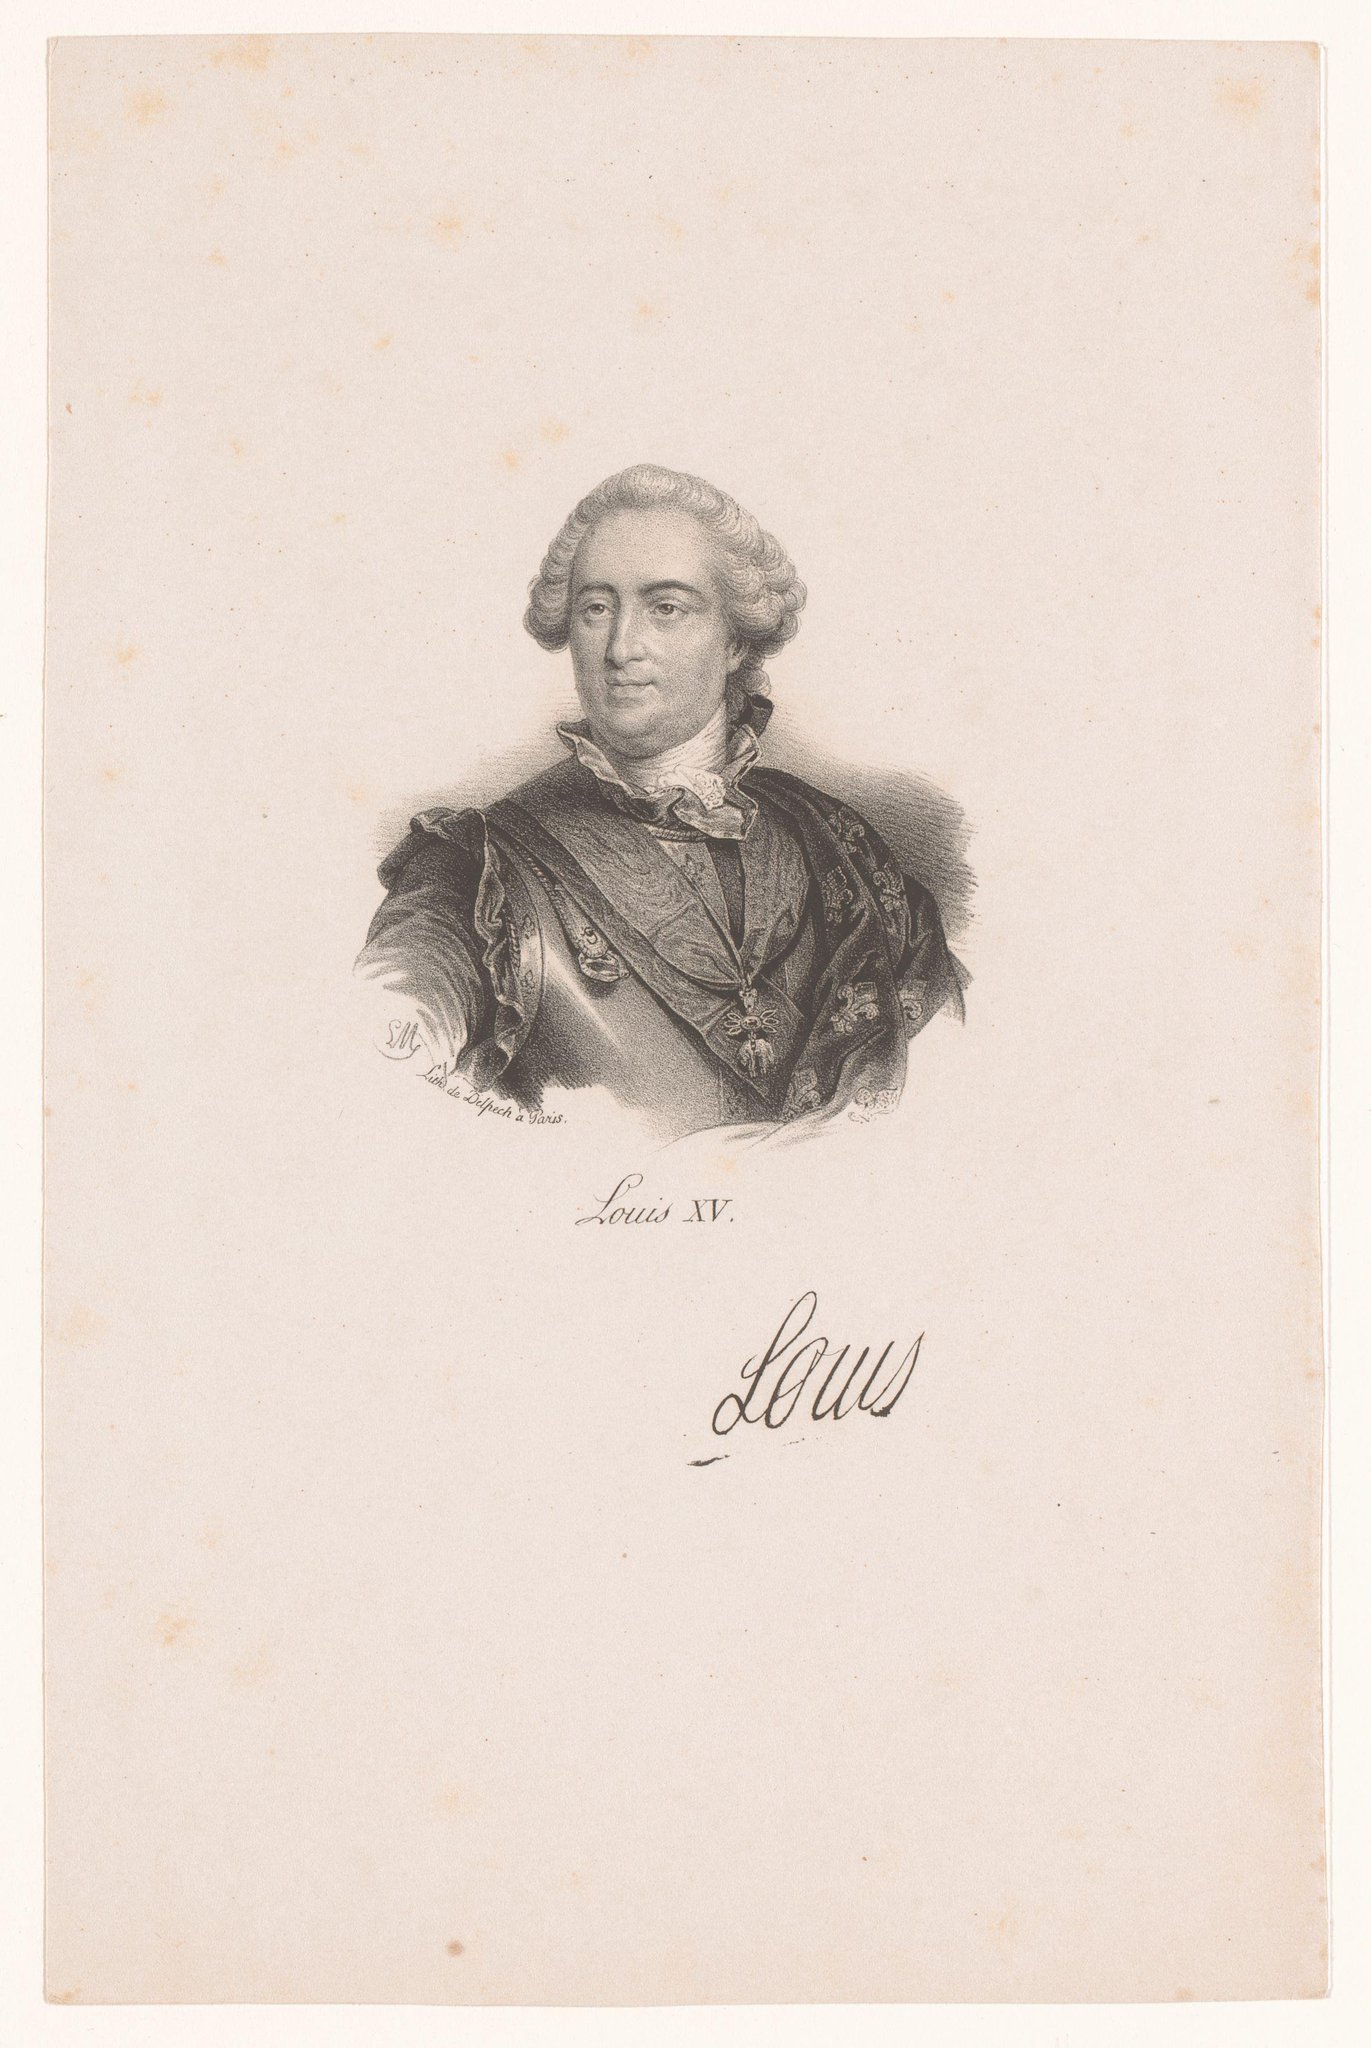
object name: print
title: Louis XV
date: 1825-1842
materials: paper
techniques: lithograph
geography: paris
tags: louis xv of france, historical persons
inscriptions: collector's mark: Lugt 2228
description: Prent waarschijnlijk gebruikt voor: Rois et reines de France: depuis l'origine de la monarchie jusqu'à nos jours. 3 dln. Parijs: veuve Delpech, 1833-1840. En/of voor: Iconographie française ou recueil des portraits des personnages les plus illustres qui ont paru en France depuis François premier jusqu'à la fin du règne de Louis XVI (…). Parijs: veuve Delpech, 1828. En/of voor: Iconographie française ou choix de deux cents portraits d'hommes et de femmes qui se sont acquis en France, depuis le règne de Charles VII jusqu'à la fin de celui de Louis XVI (…). Parijs: veuve Delpech, 1840. Mogelijk komt de prent ook voor in eerdere en/of latere publicaties uitgegeven door veuve Delpech of haar opvolger Rosselin.